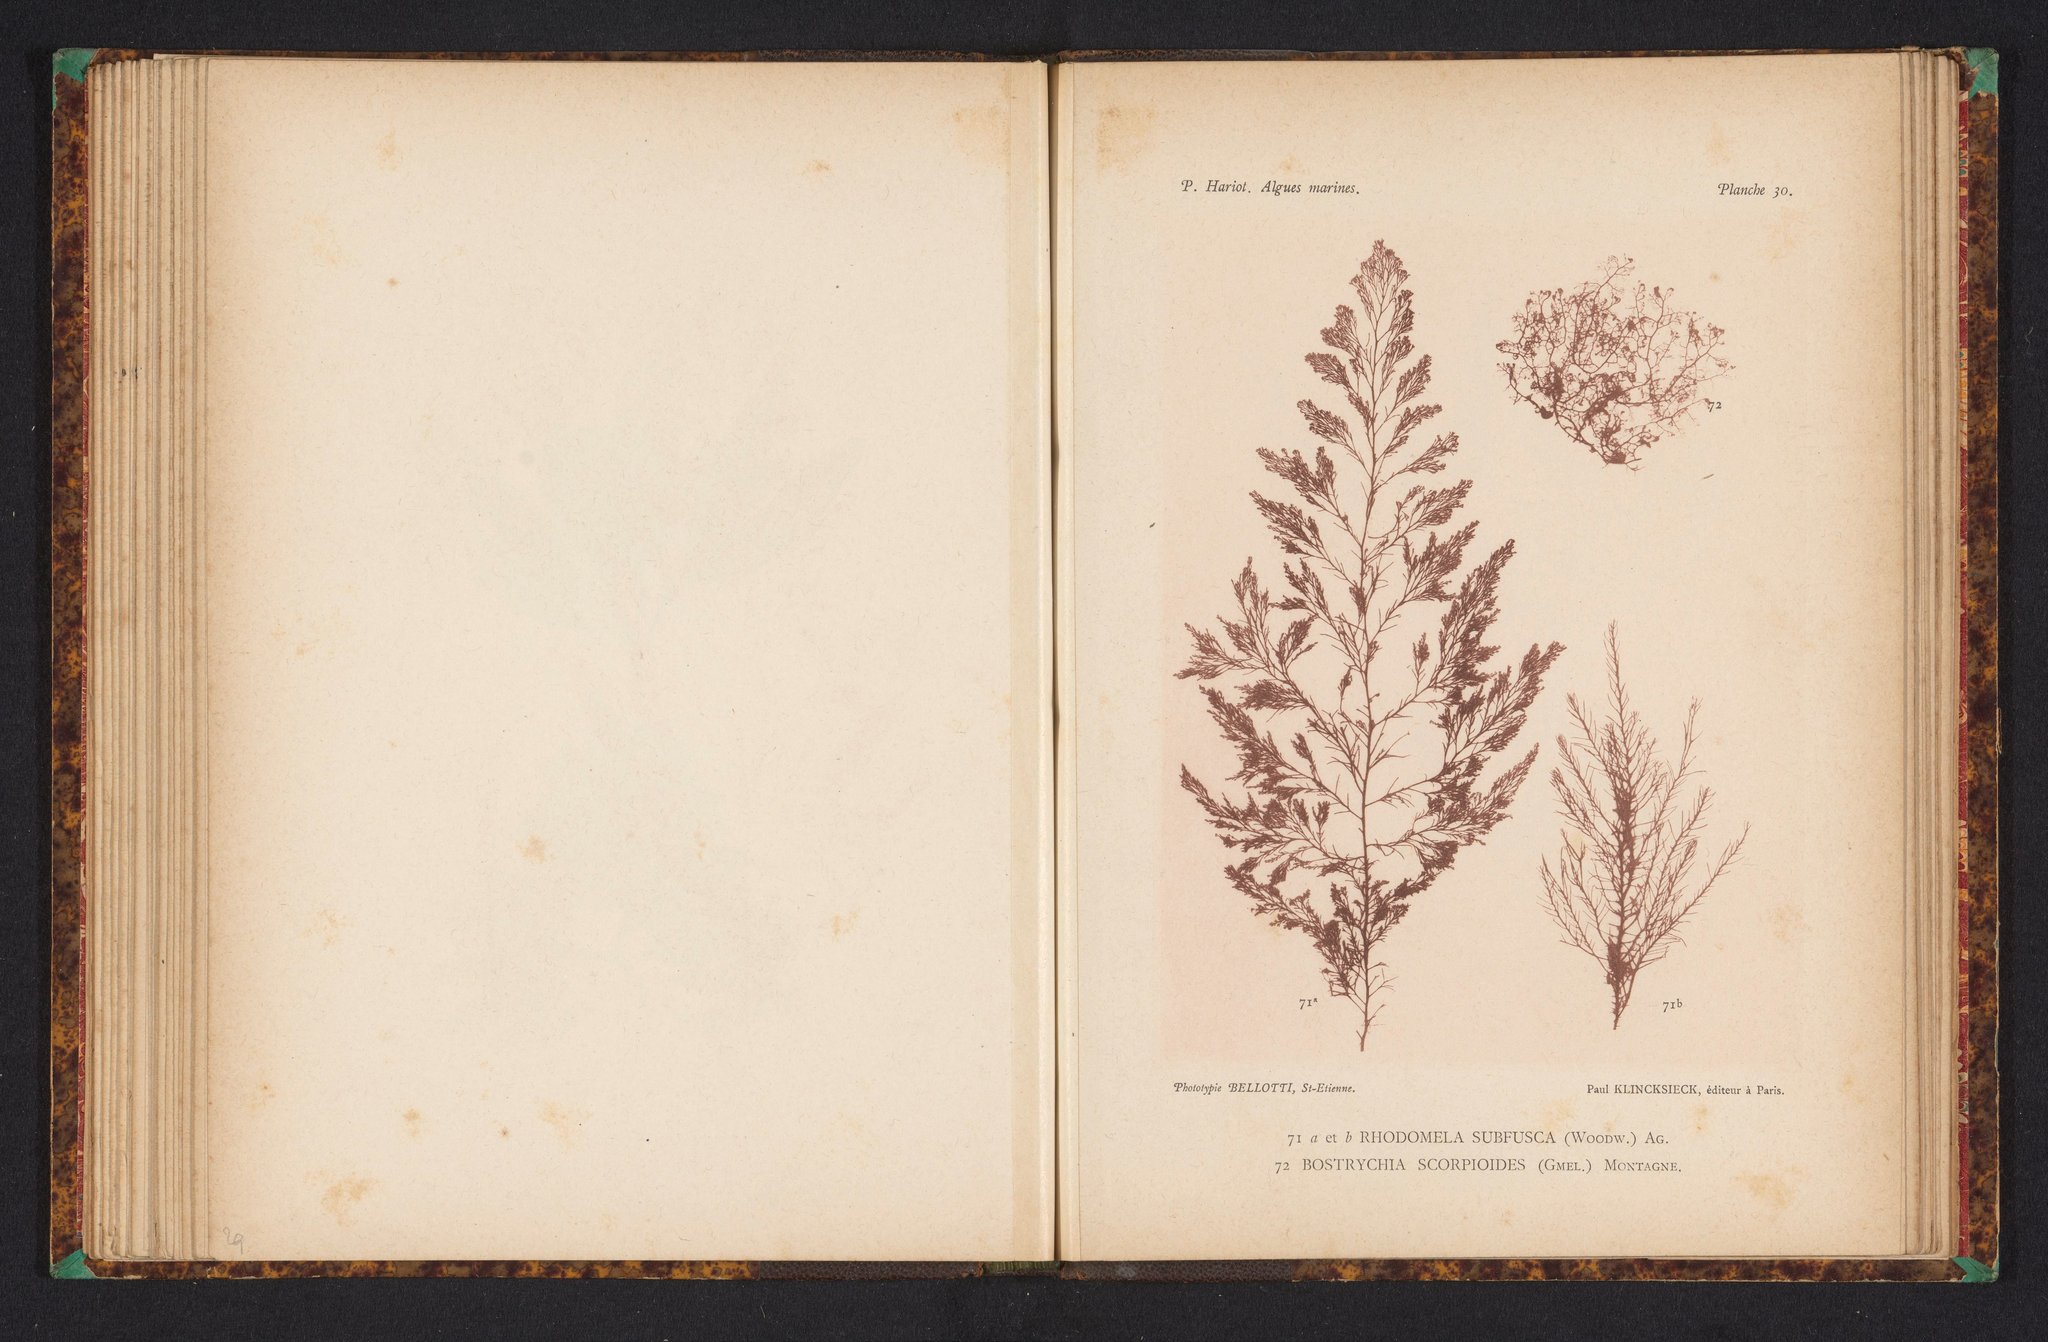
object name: photomechanical print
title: Twee soorten zeewier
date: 1882-1892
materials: paper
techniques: photograph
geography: saint-étienne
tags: algae, seaweed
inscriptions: number: ‘71 a (...) 72’, inscription: ‘Rhodomela (...) scorpioides (Gmel.) Montagne.’, number: ‘Planche 30.’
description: (71a) en (71b) is Rhodomela subfusca, (72) is Bostrychia scorpioides.